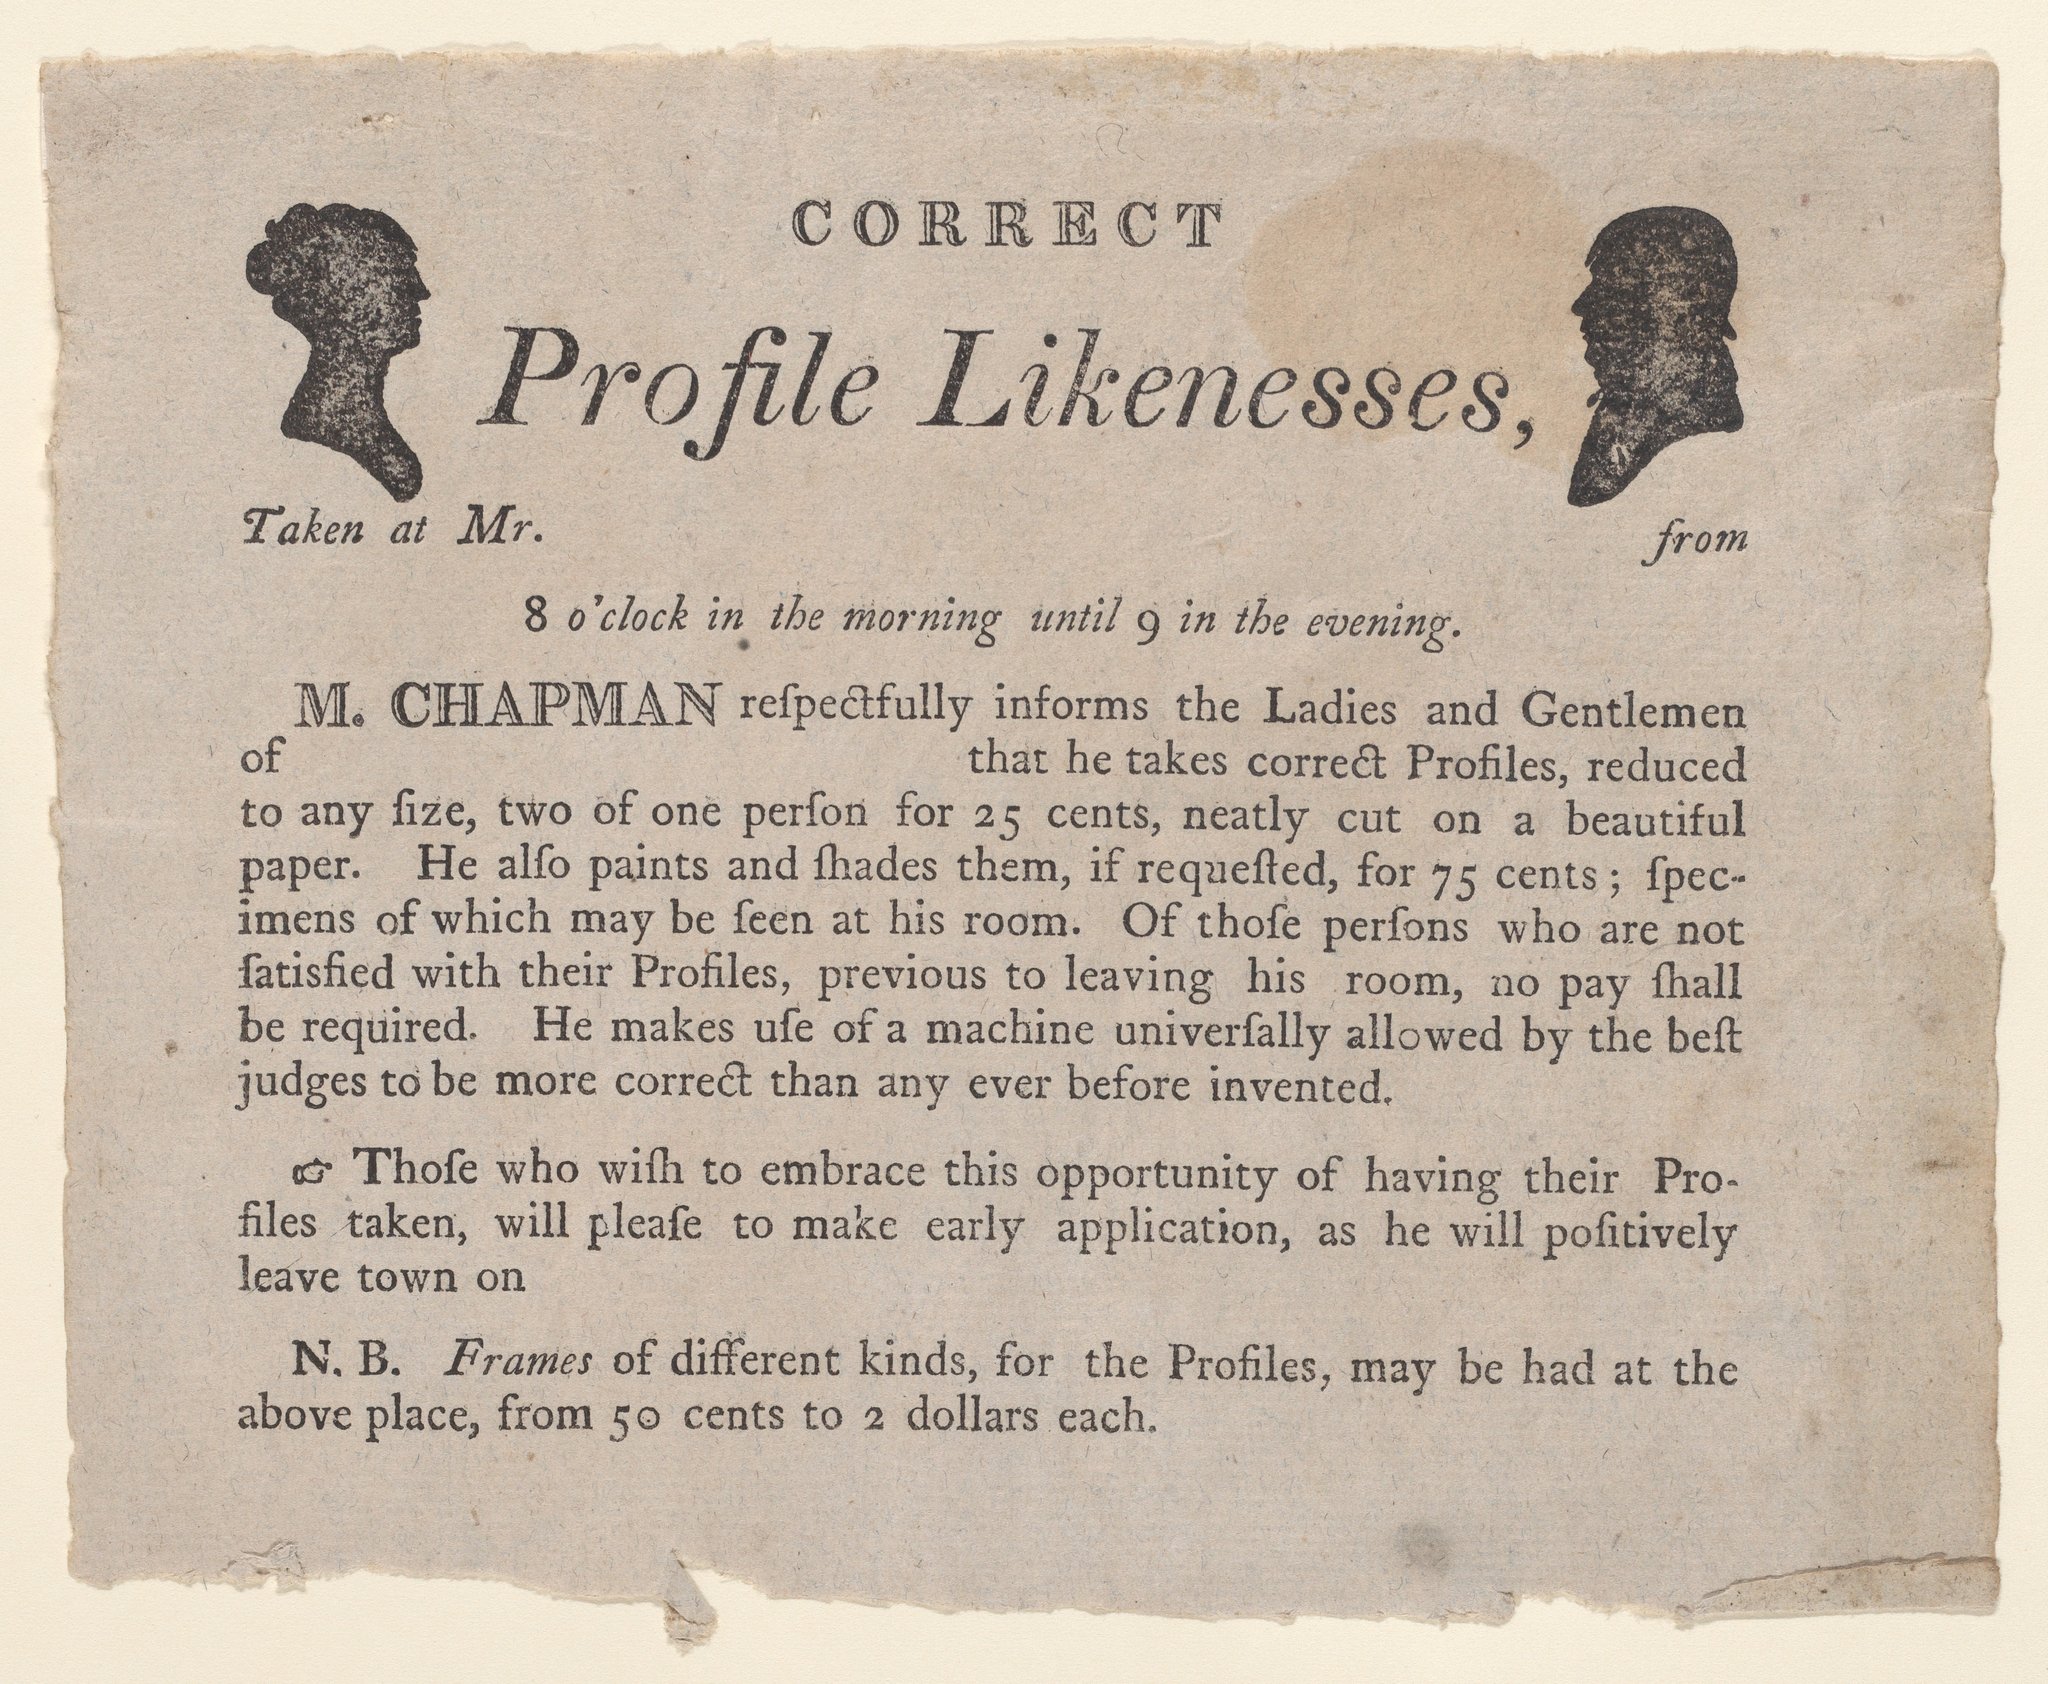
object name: print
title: Advertisement for profile likenesses by Moses Chapman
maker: Anonymous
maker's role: artist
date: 1803-1821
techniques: letterpress